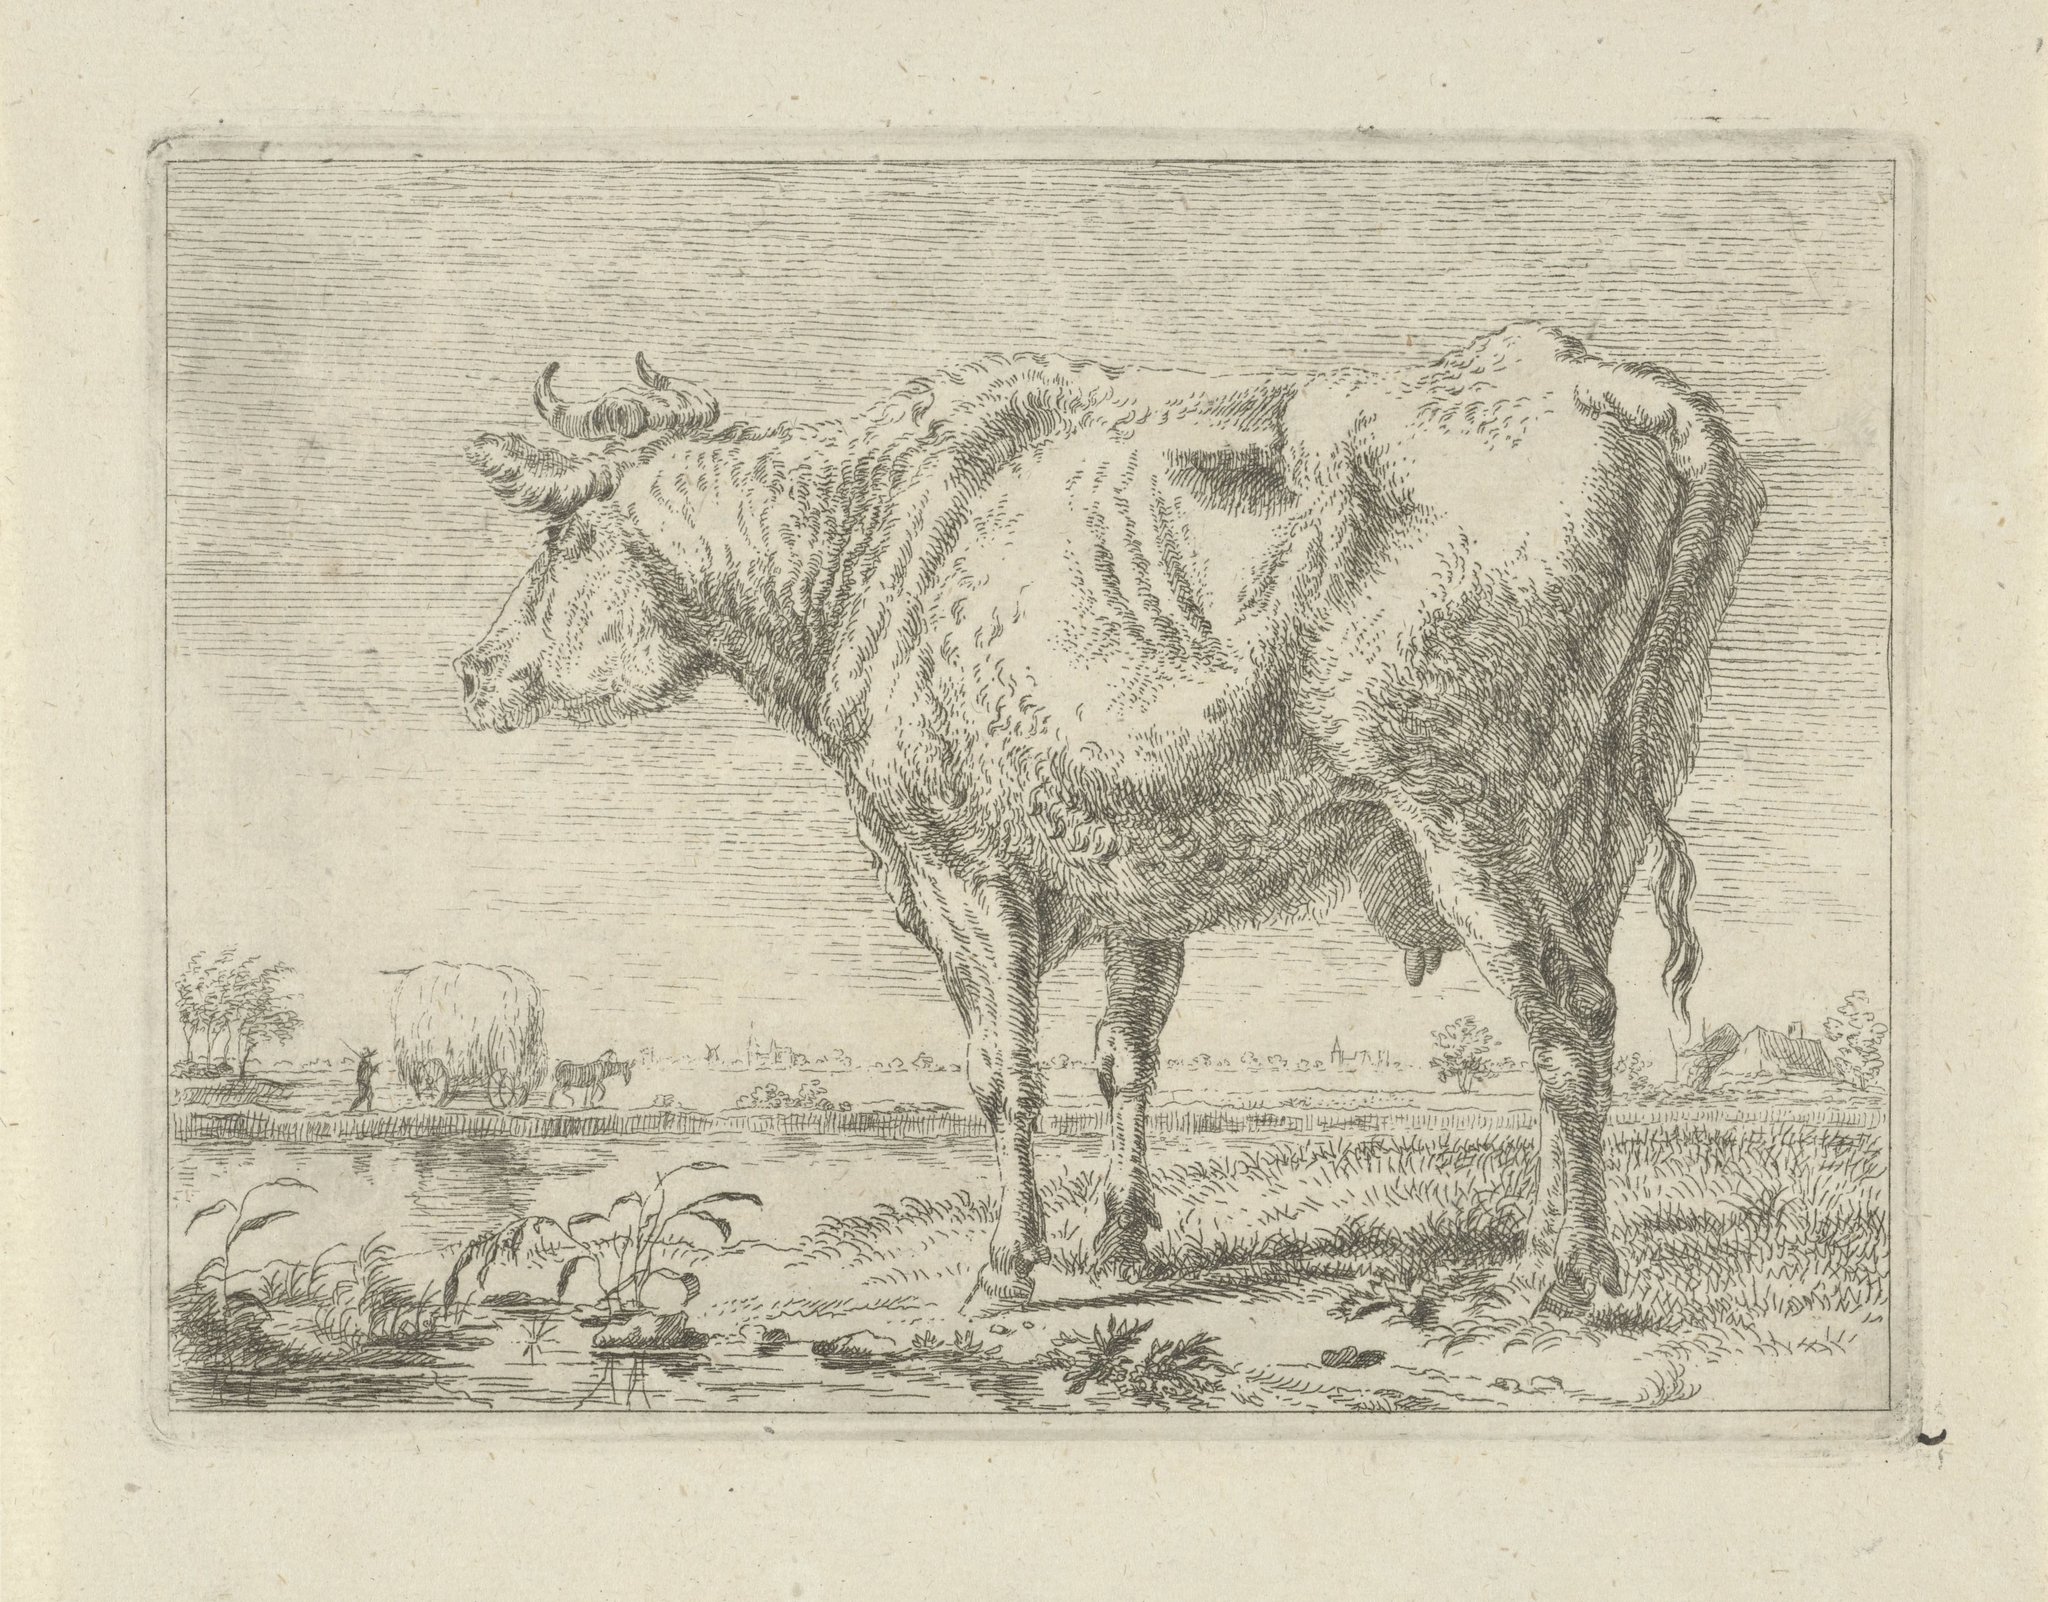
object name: print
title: Staande koe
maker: Anonymous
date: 1798-1849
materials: paper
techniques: etching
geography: netherlands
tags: cow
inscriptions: collector's mark: Lugt 2228